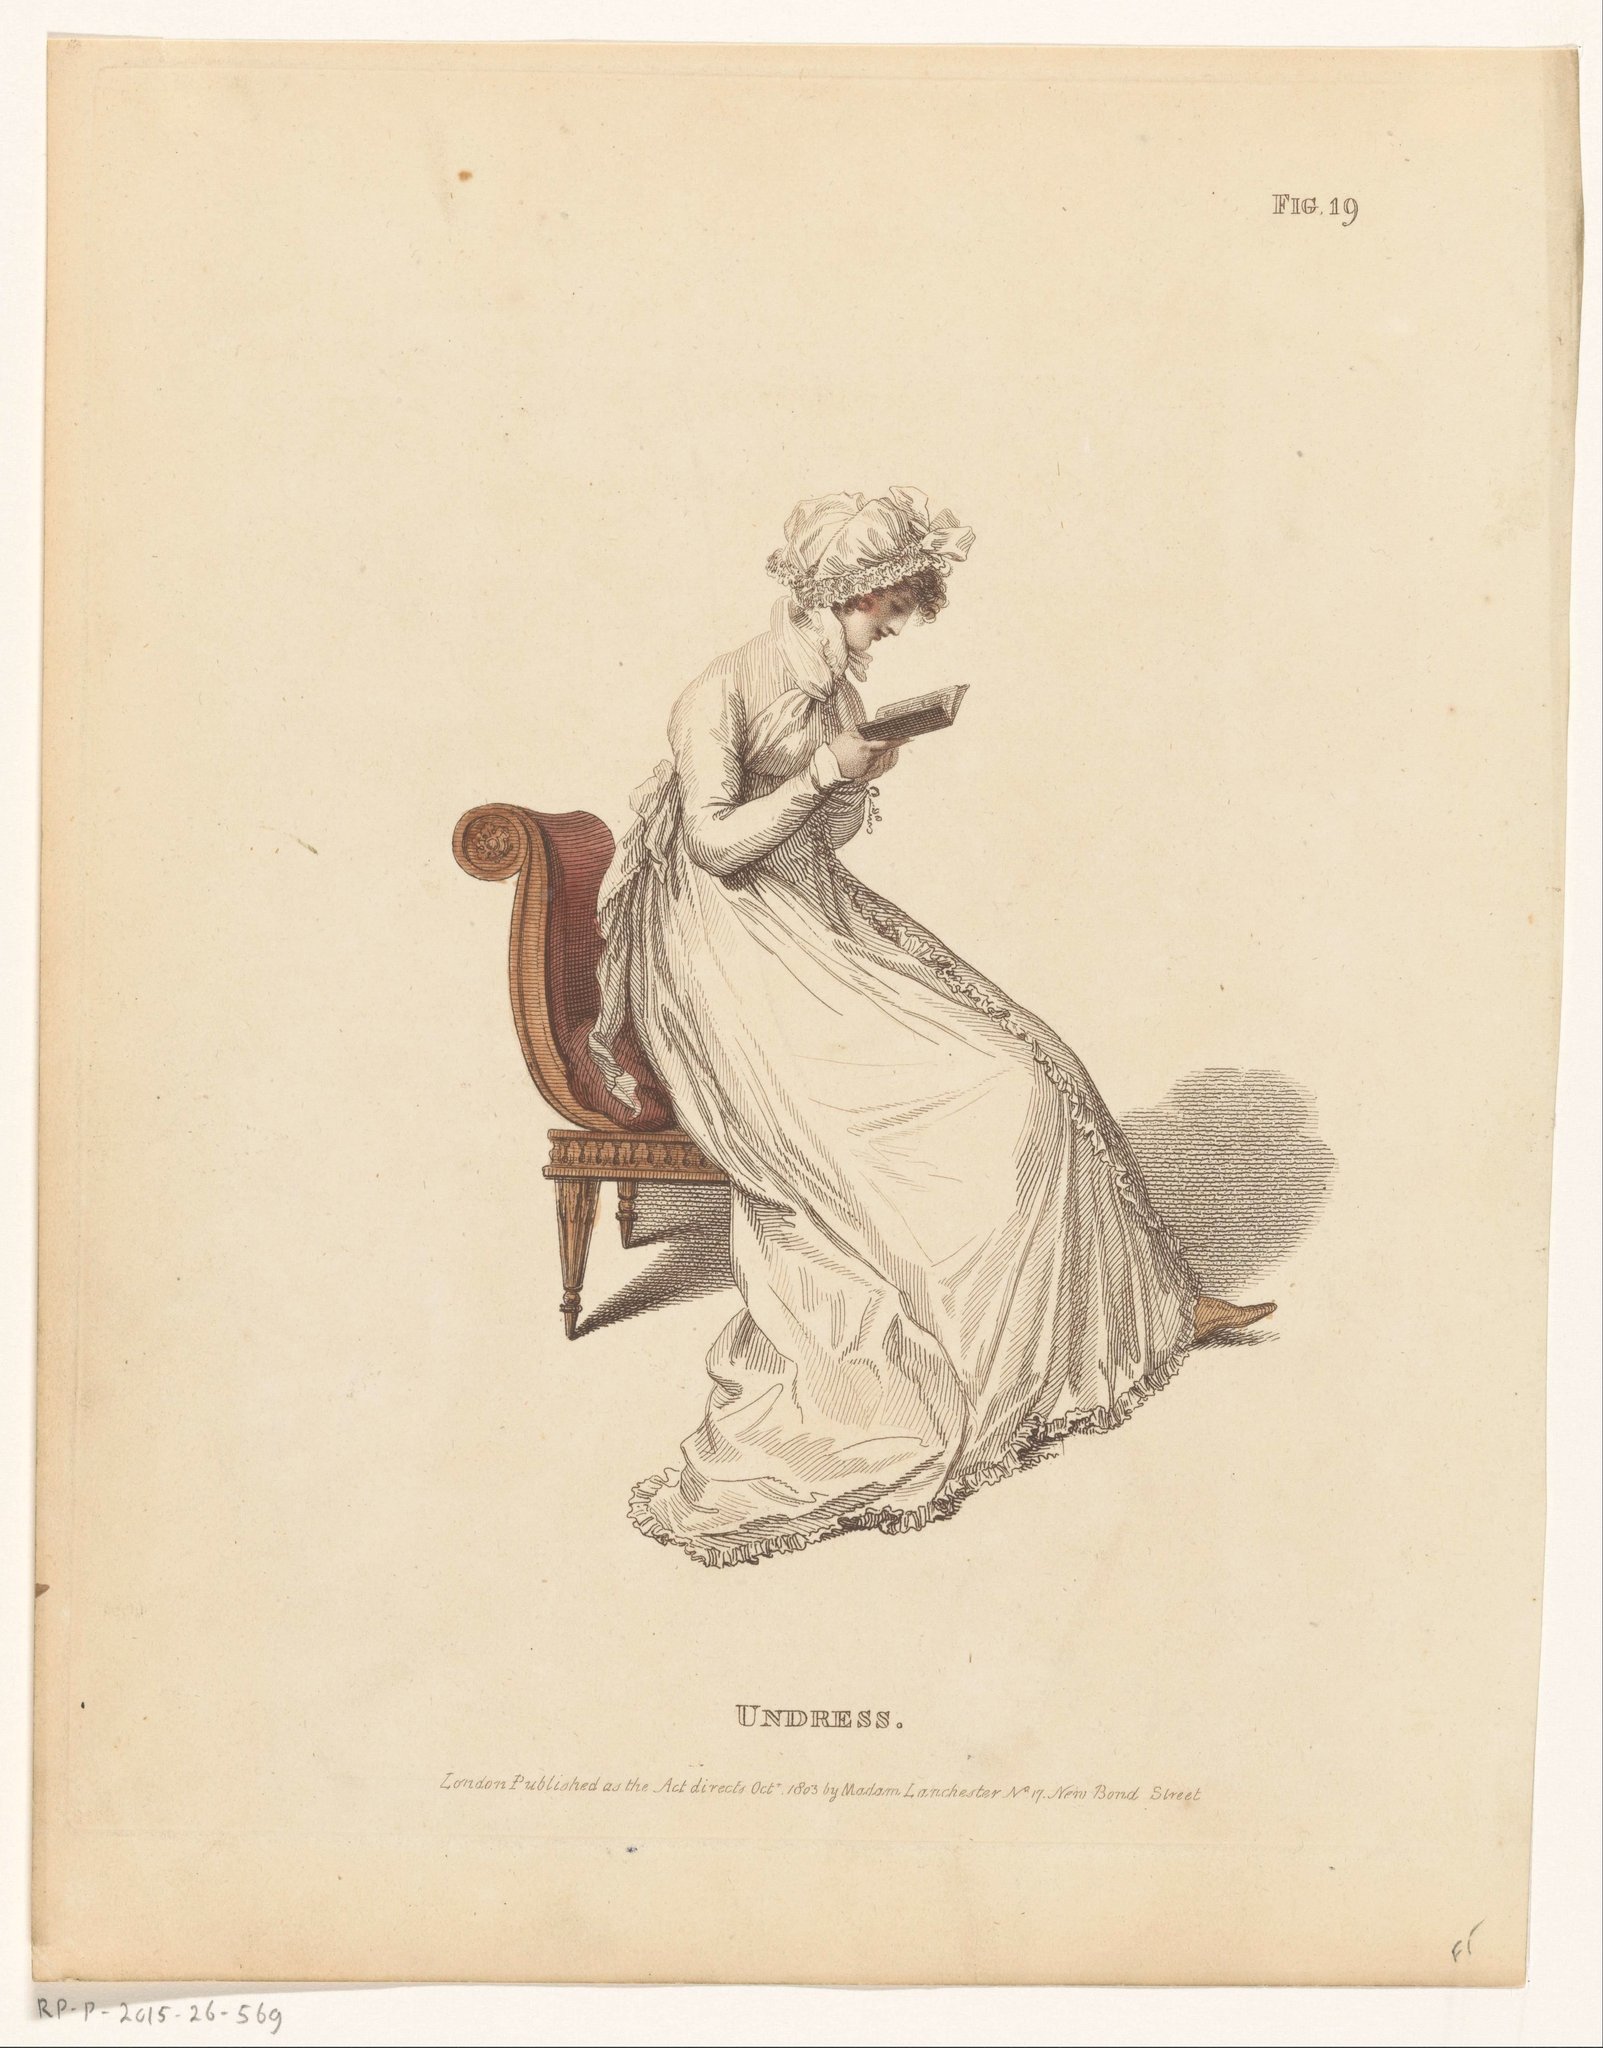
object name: print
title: Undress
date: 1803-1810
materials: paper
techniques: etching, hand coloring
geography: london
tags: dress, gown: morning dress (+ women's clothes), book, newspaper, news-sheet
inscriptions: collector's mark: Lugt 2228, collector's mark: Lugt 4779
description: Prent gepubliceerd in het tijdschrift Mirroir de la Mode, verschenen tussen januari en december 1803 en daarna gepubliceerd als verzameling van 25 prenten.